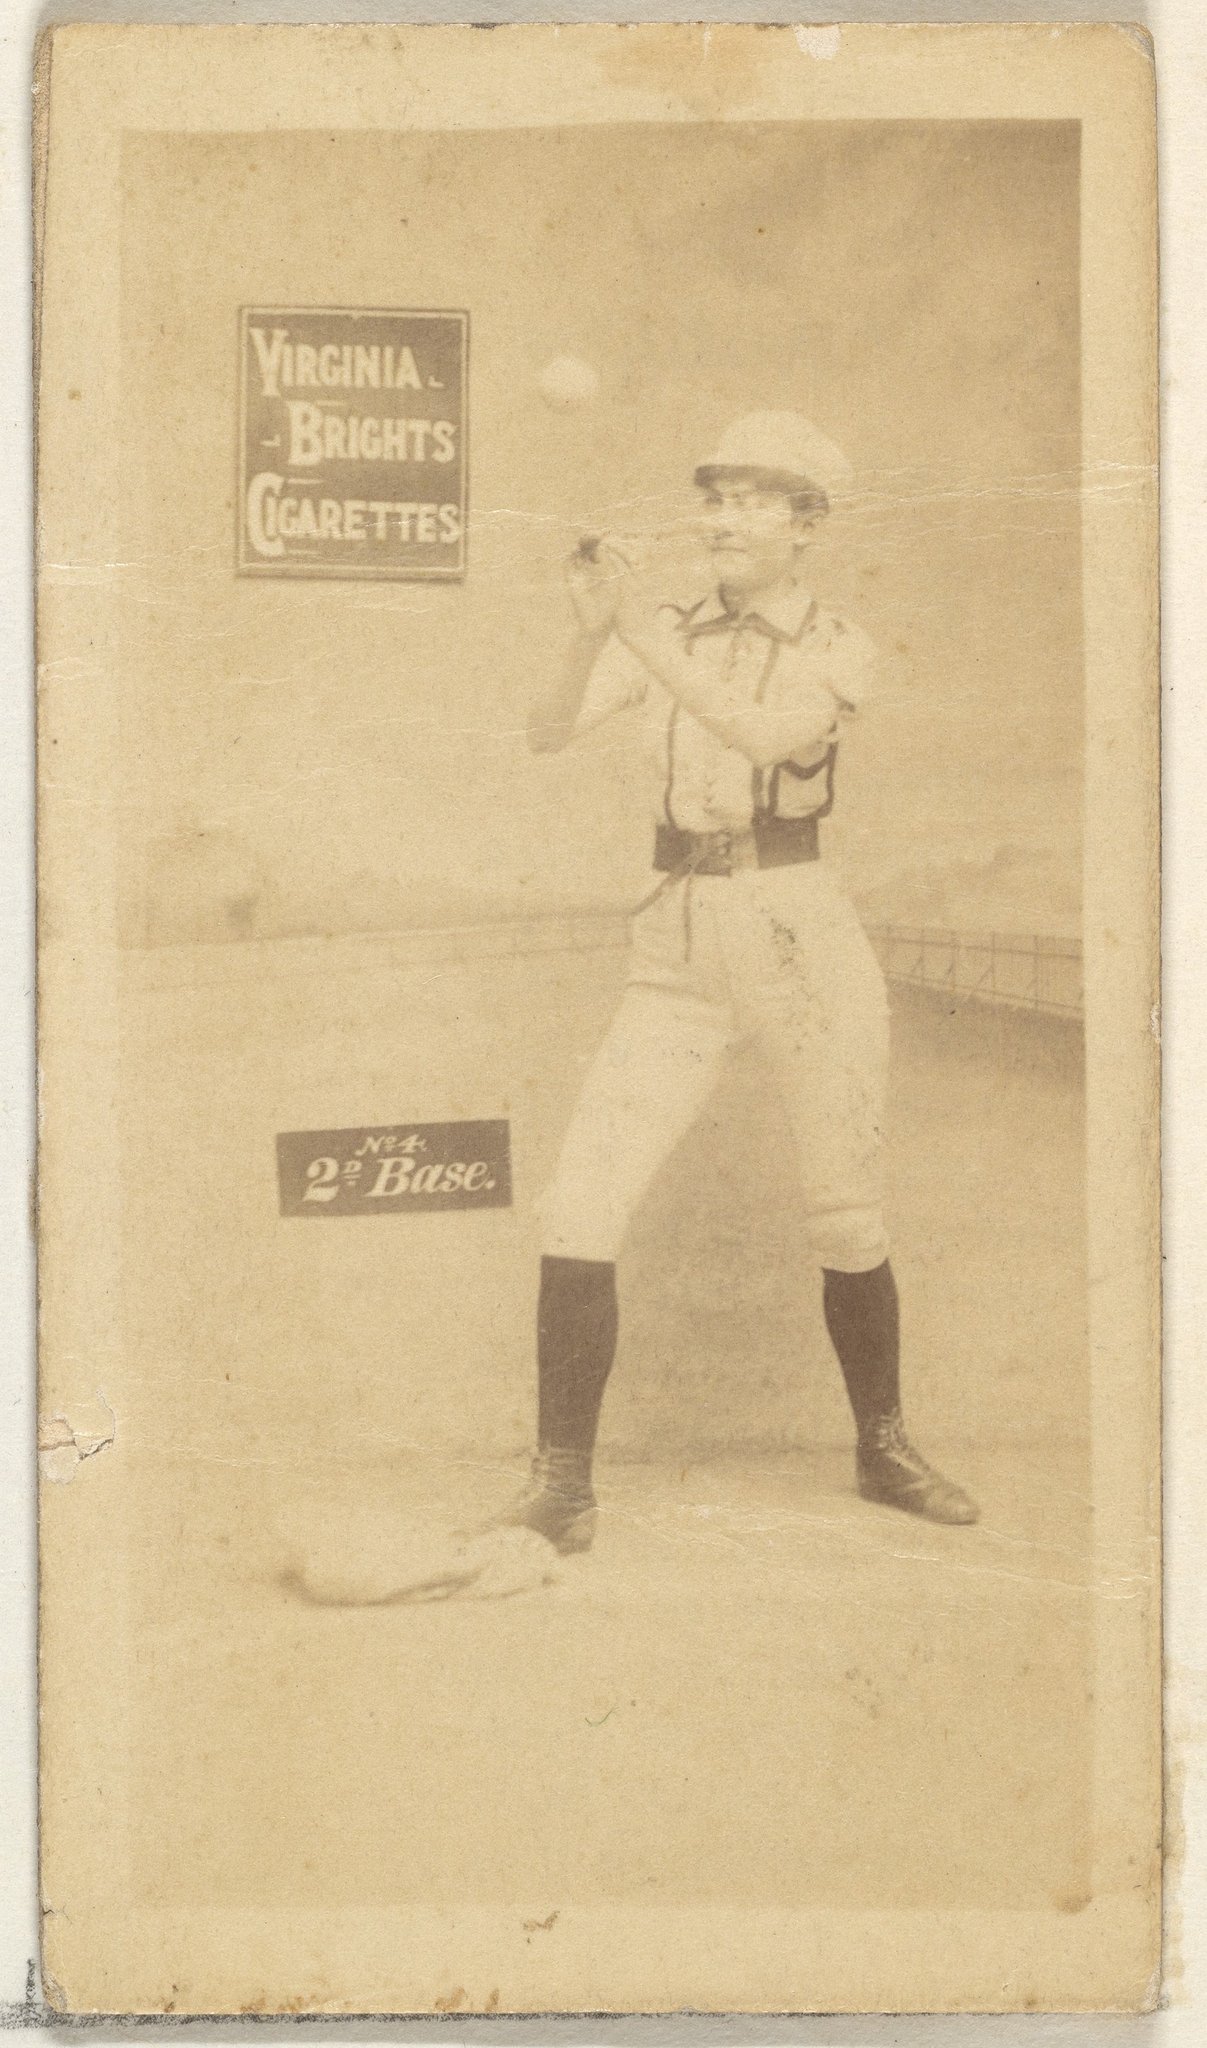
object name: baseball card, photograph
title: 2nd Base, from the Girl Baseball Players series (N48, Type 2) for Virginia Brights Cigarettes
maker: allen & ginter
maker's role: publisher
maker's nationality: american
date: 1886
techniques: albumen silver print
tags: portraits,women,baseball,athletes